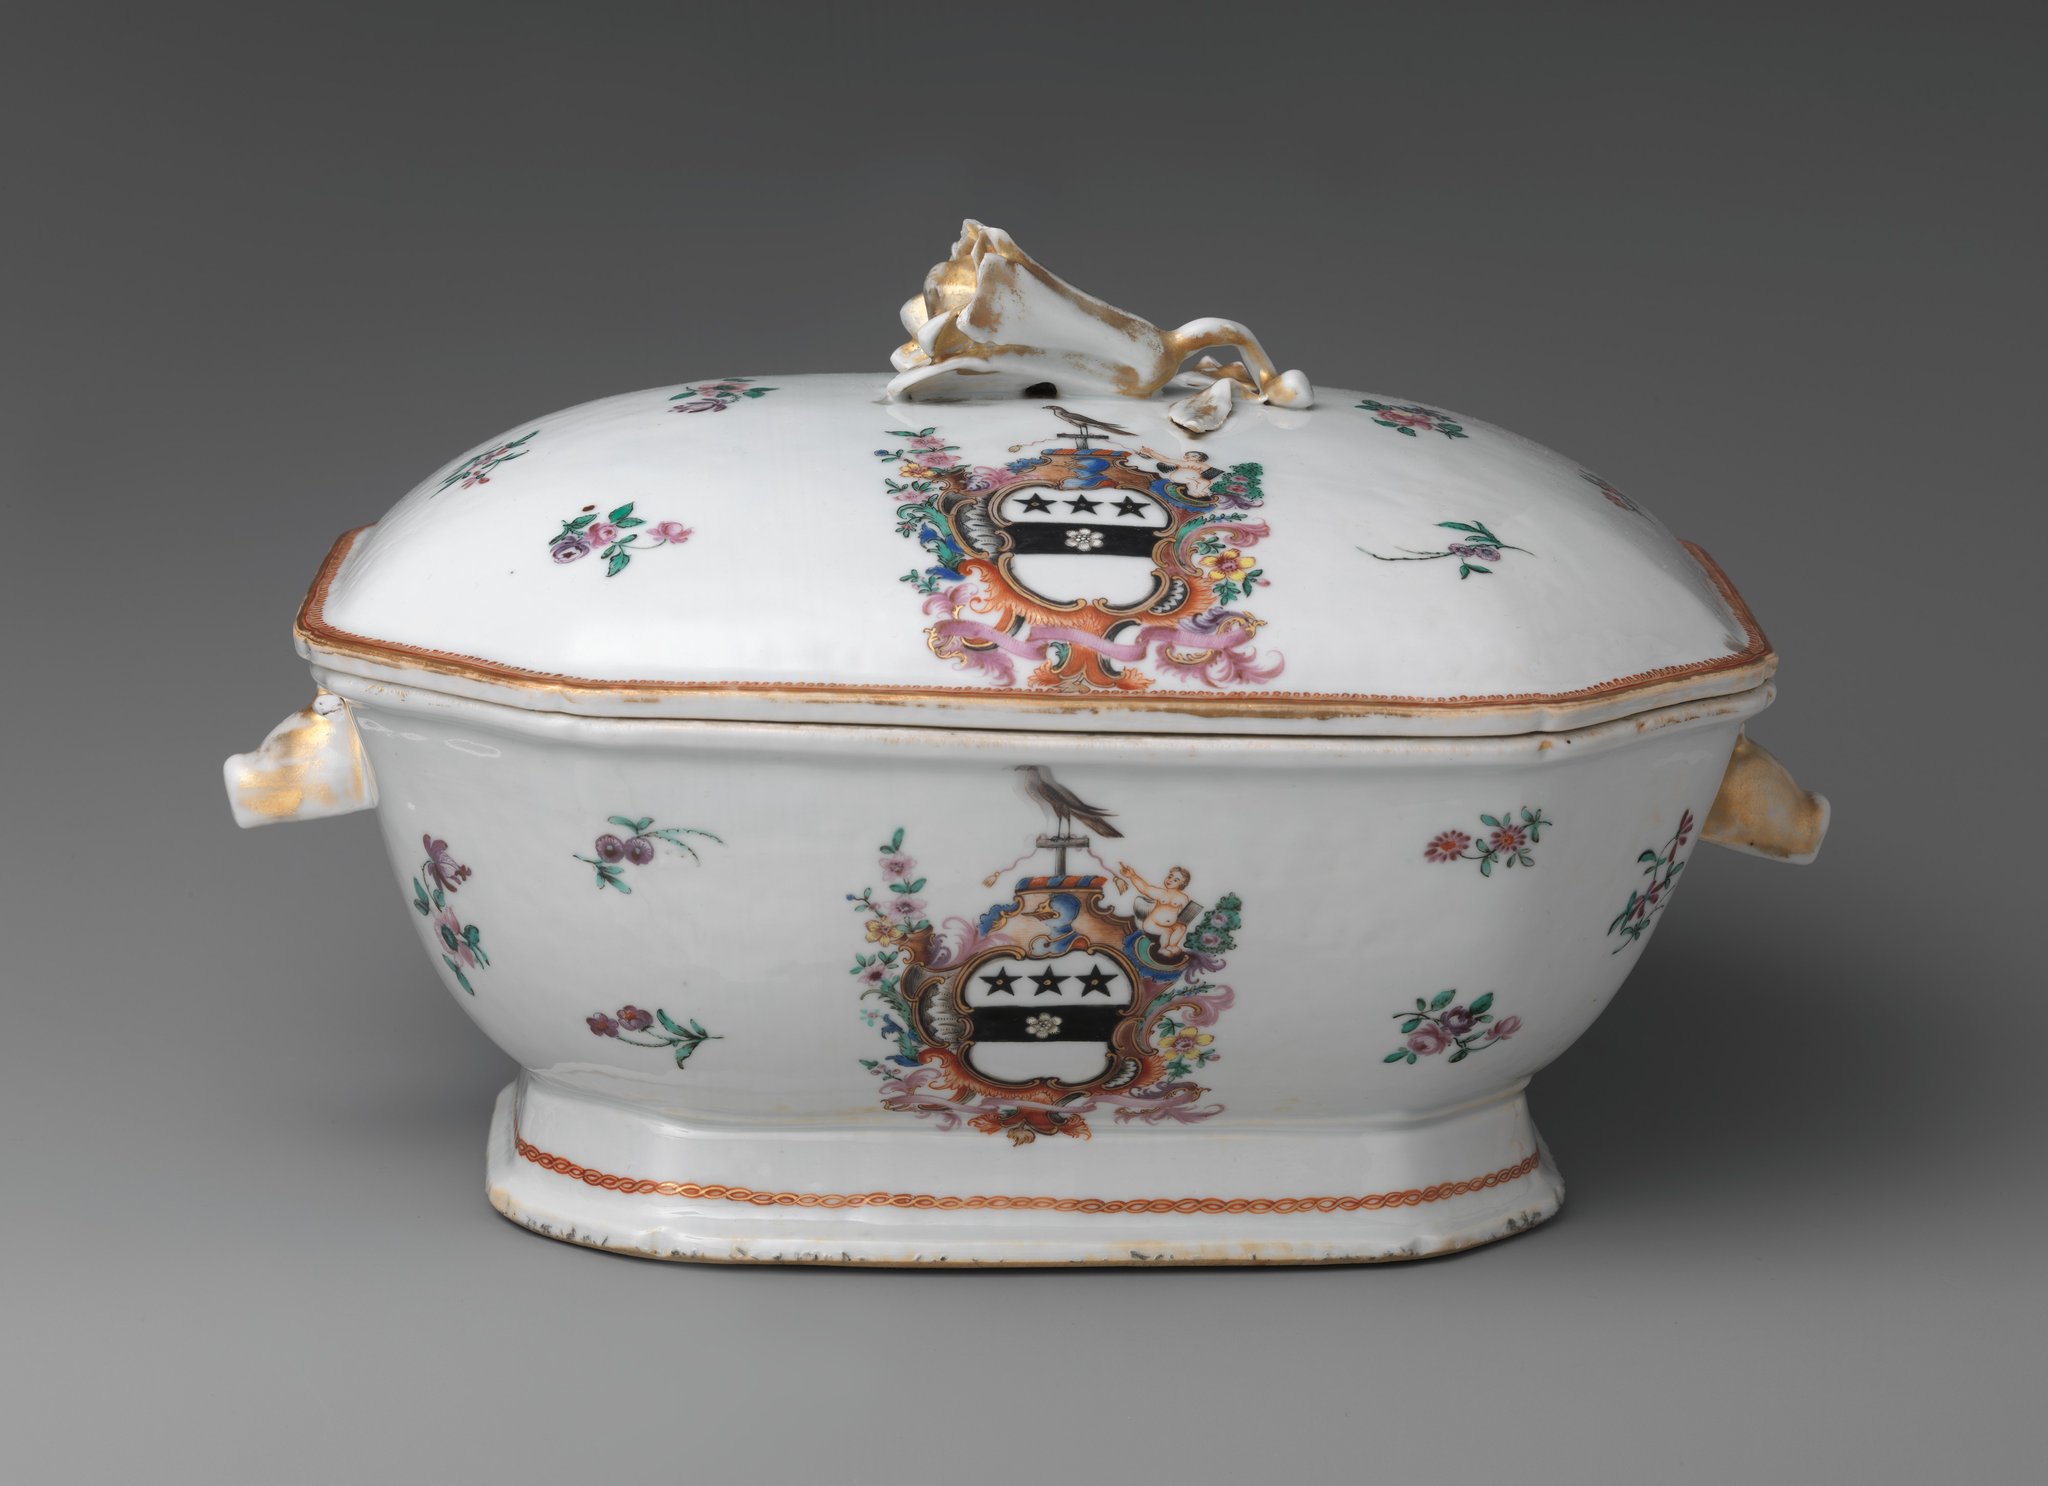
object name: soup tureen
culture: chinese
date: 1785-1790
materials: porcelain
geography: china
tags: coat of arms